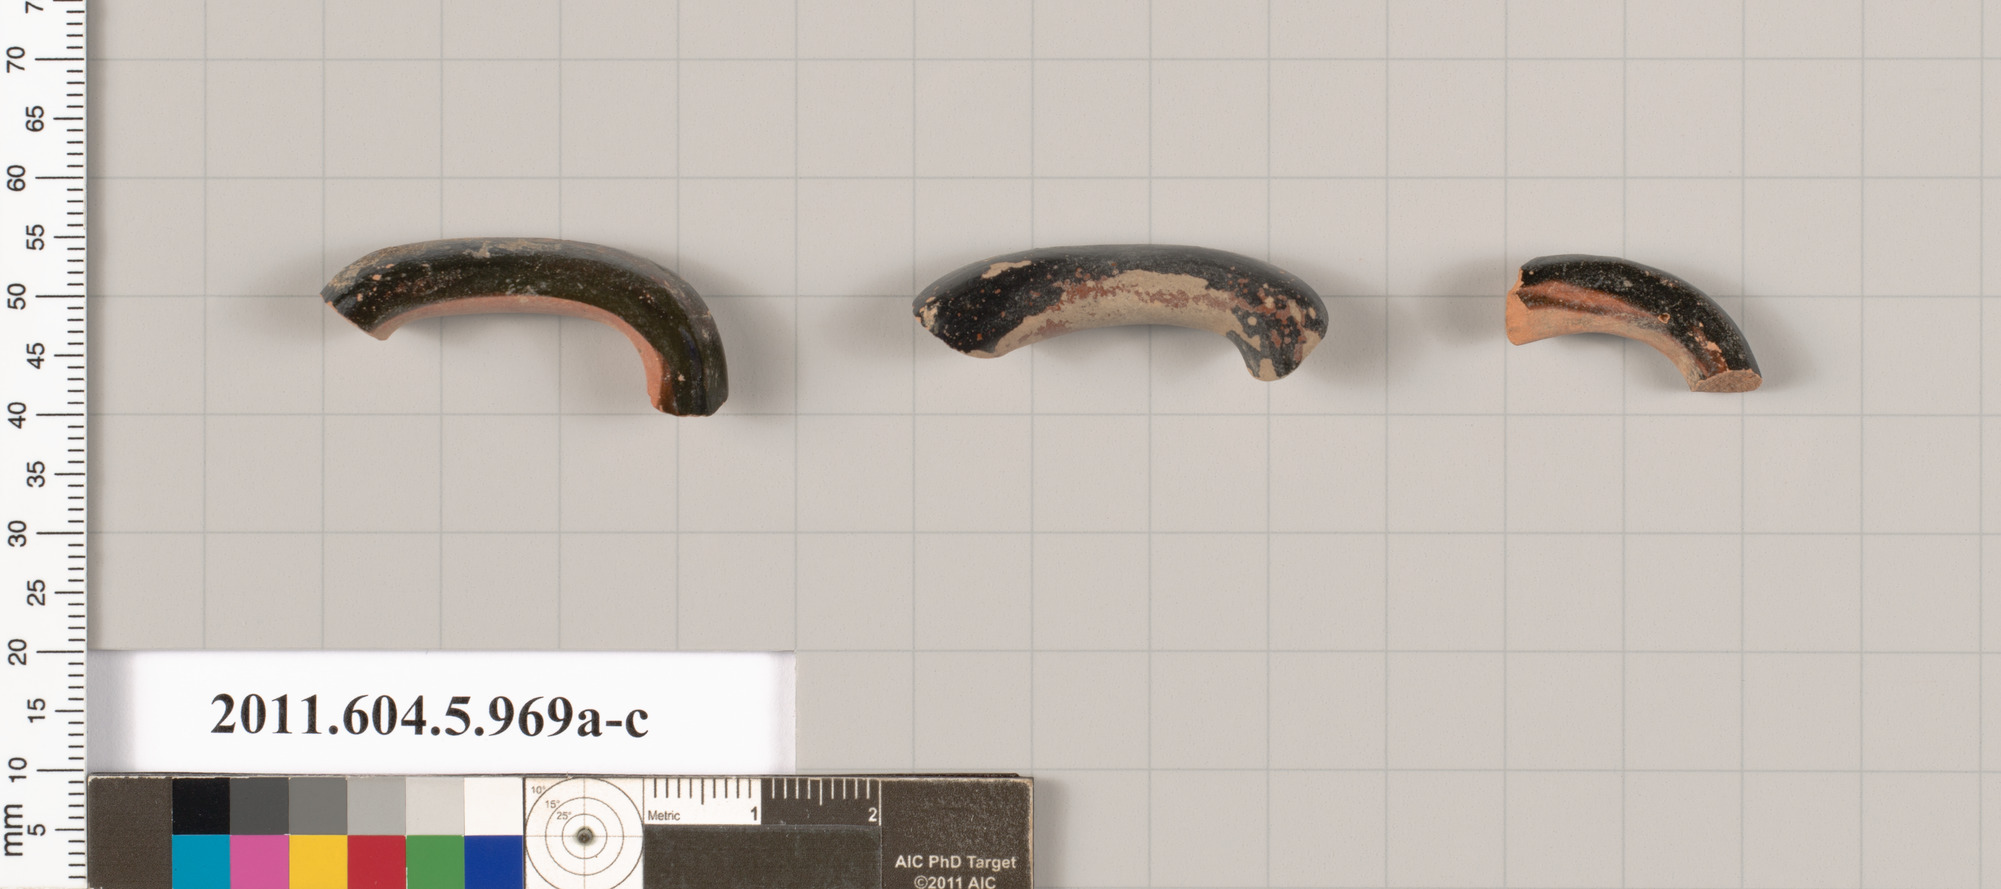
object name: kylix fragment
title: Terracotta fragments of kylikes (drinking cups)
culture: greek, attic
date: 600-401 BCE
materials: terracotta